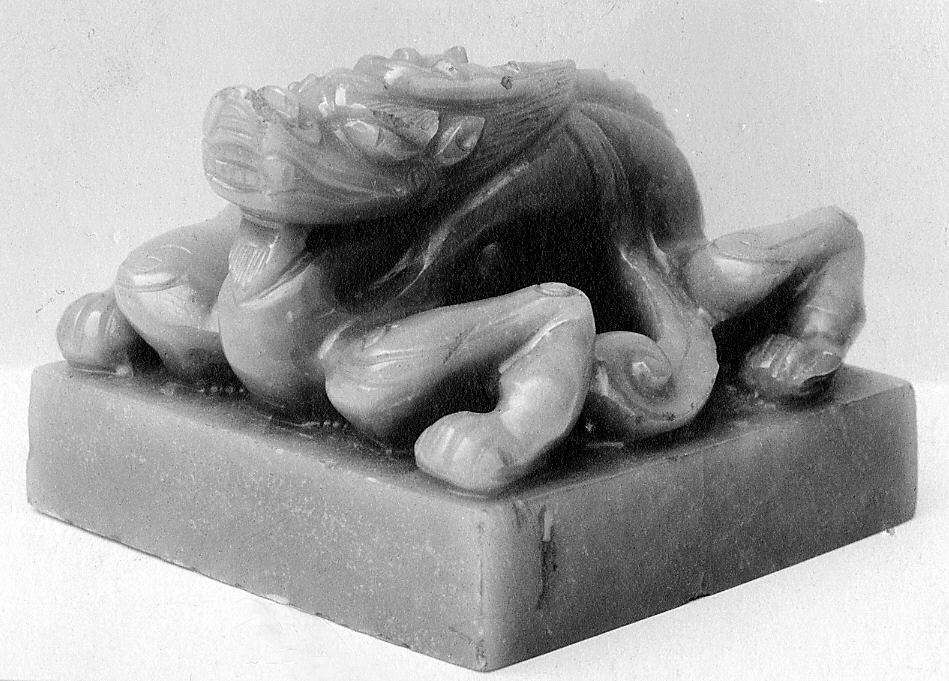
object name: imperial seal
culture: chinese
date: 960-1279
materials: jade